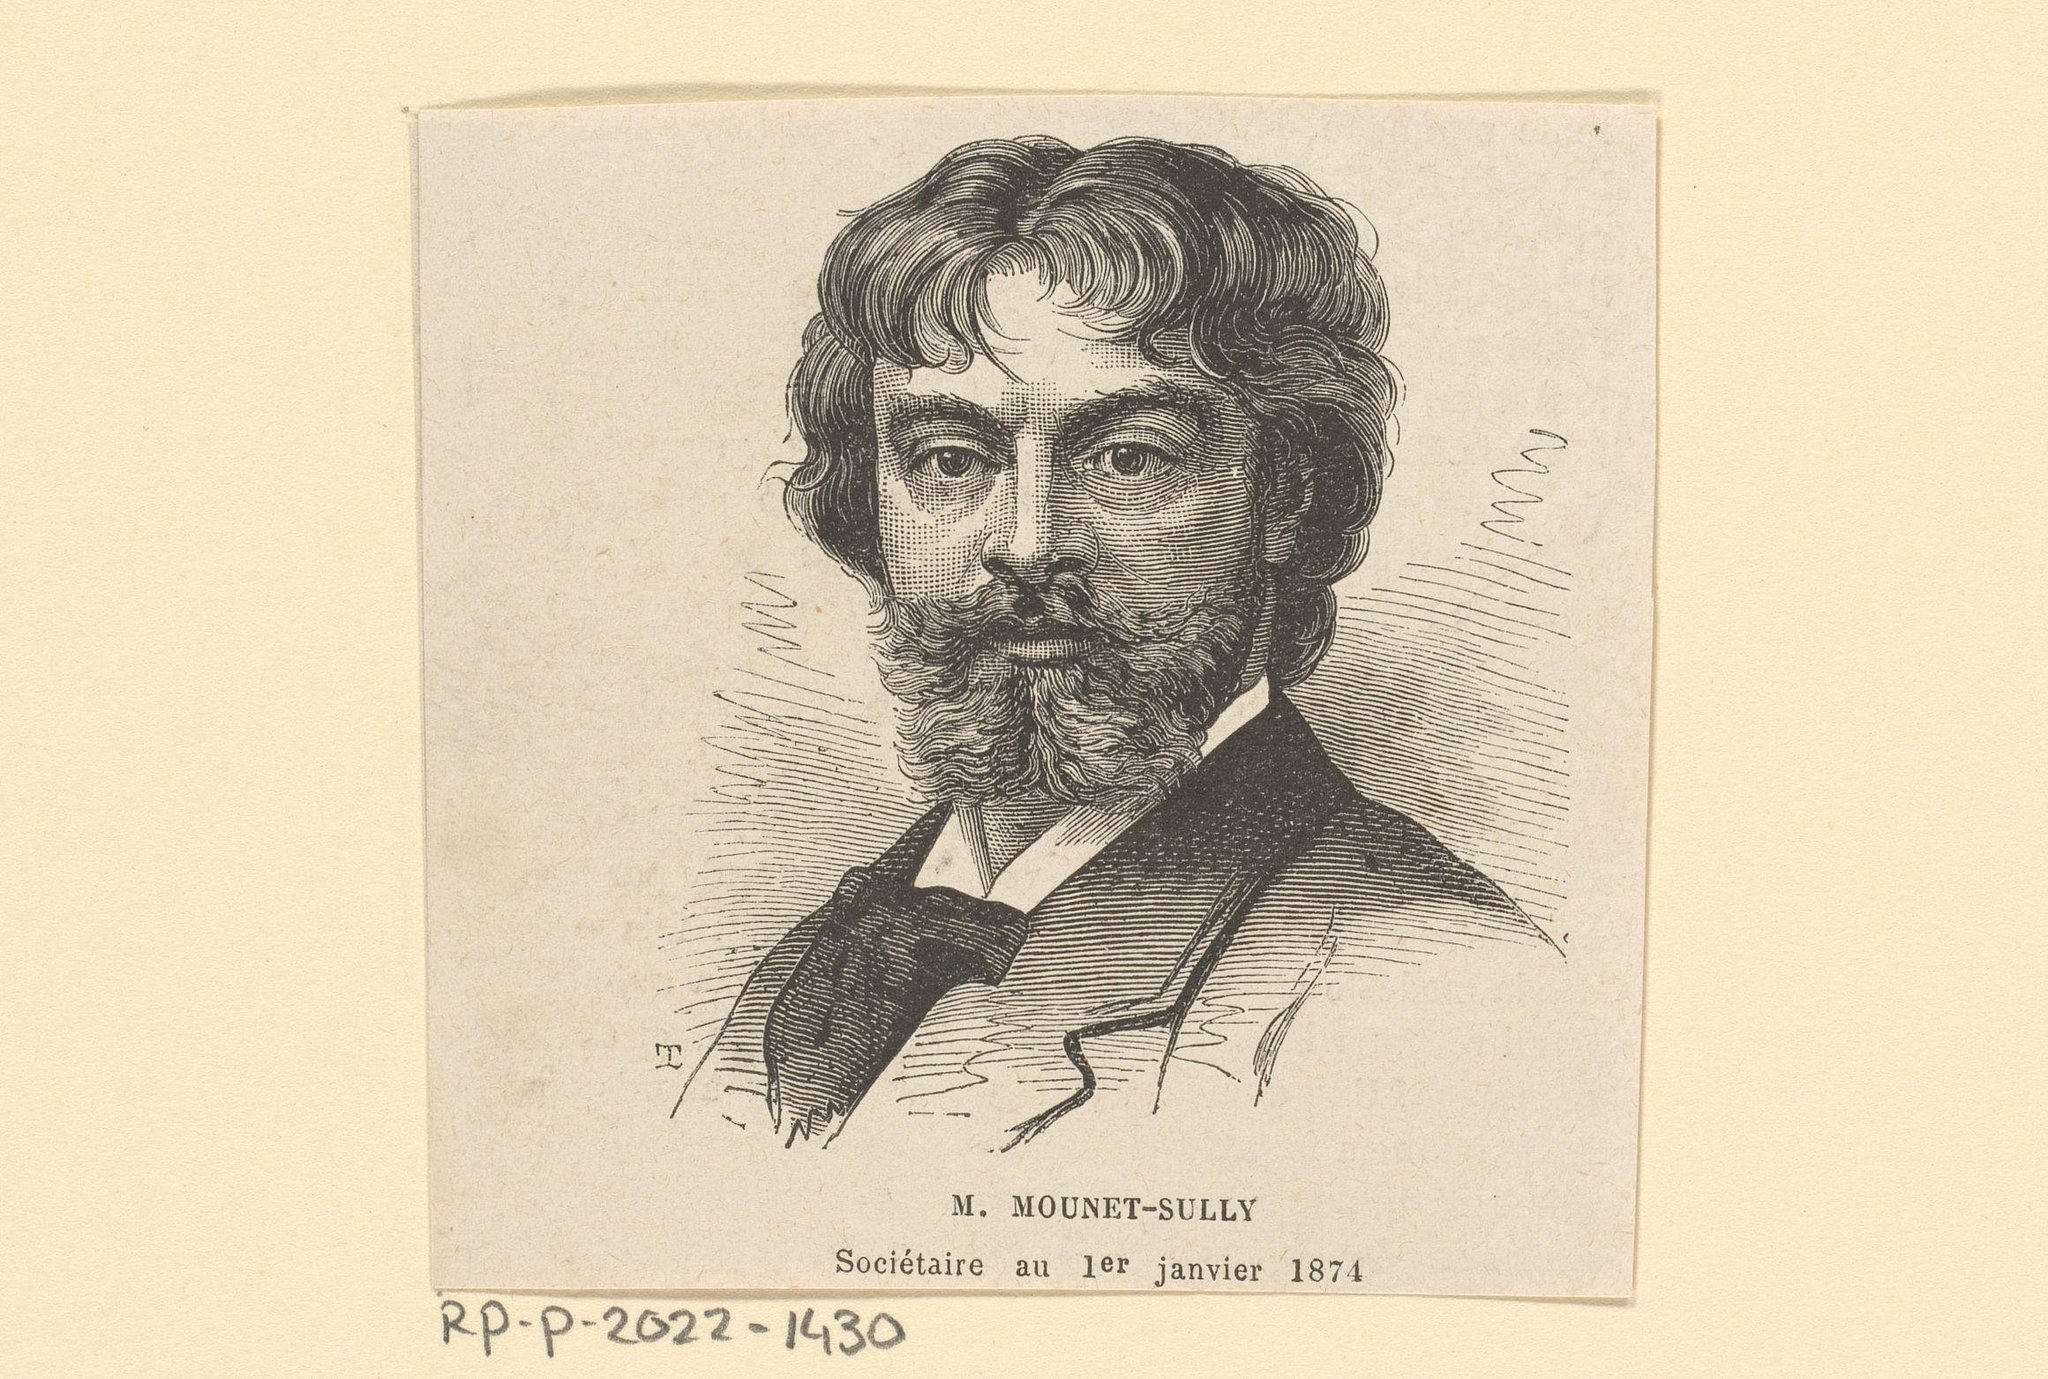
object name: print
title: Portret van Jean Mounet-Sully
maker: Anonymous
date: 1879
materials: paper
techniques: letterpress printing, engraving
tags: paris, historical persons, portrait of actor, actress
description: Prent uit: Le monde illustré 22-22 (1879), p. 108.